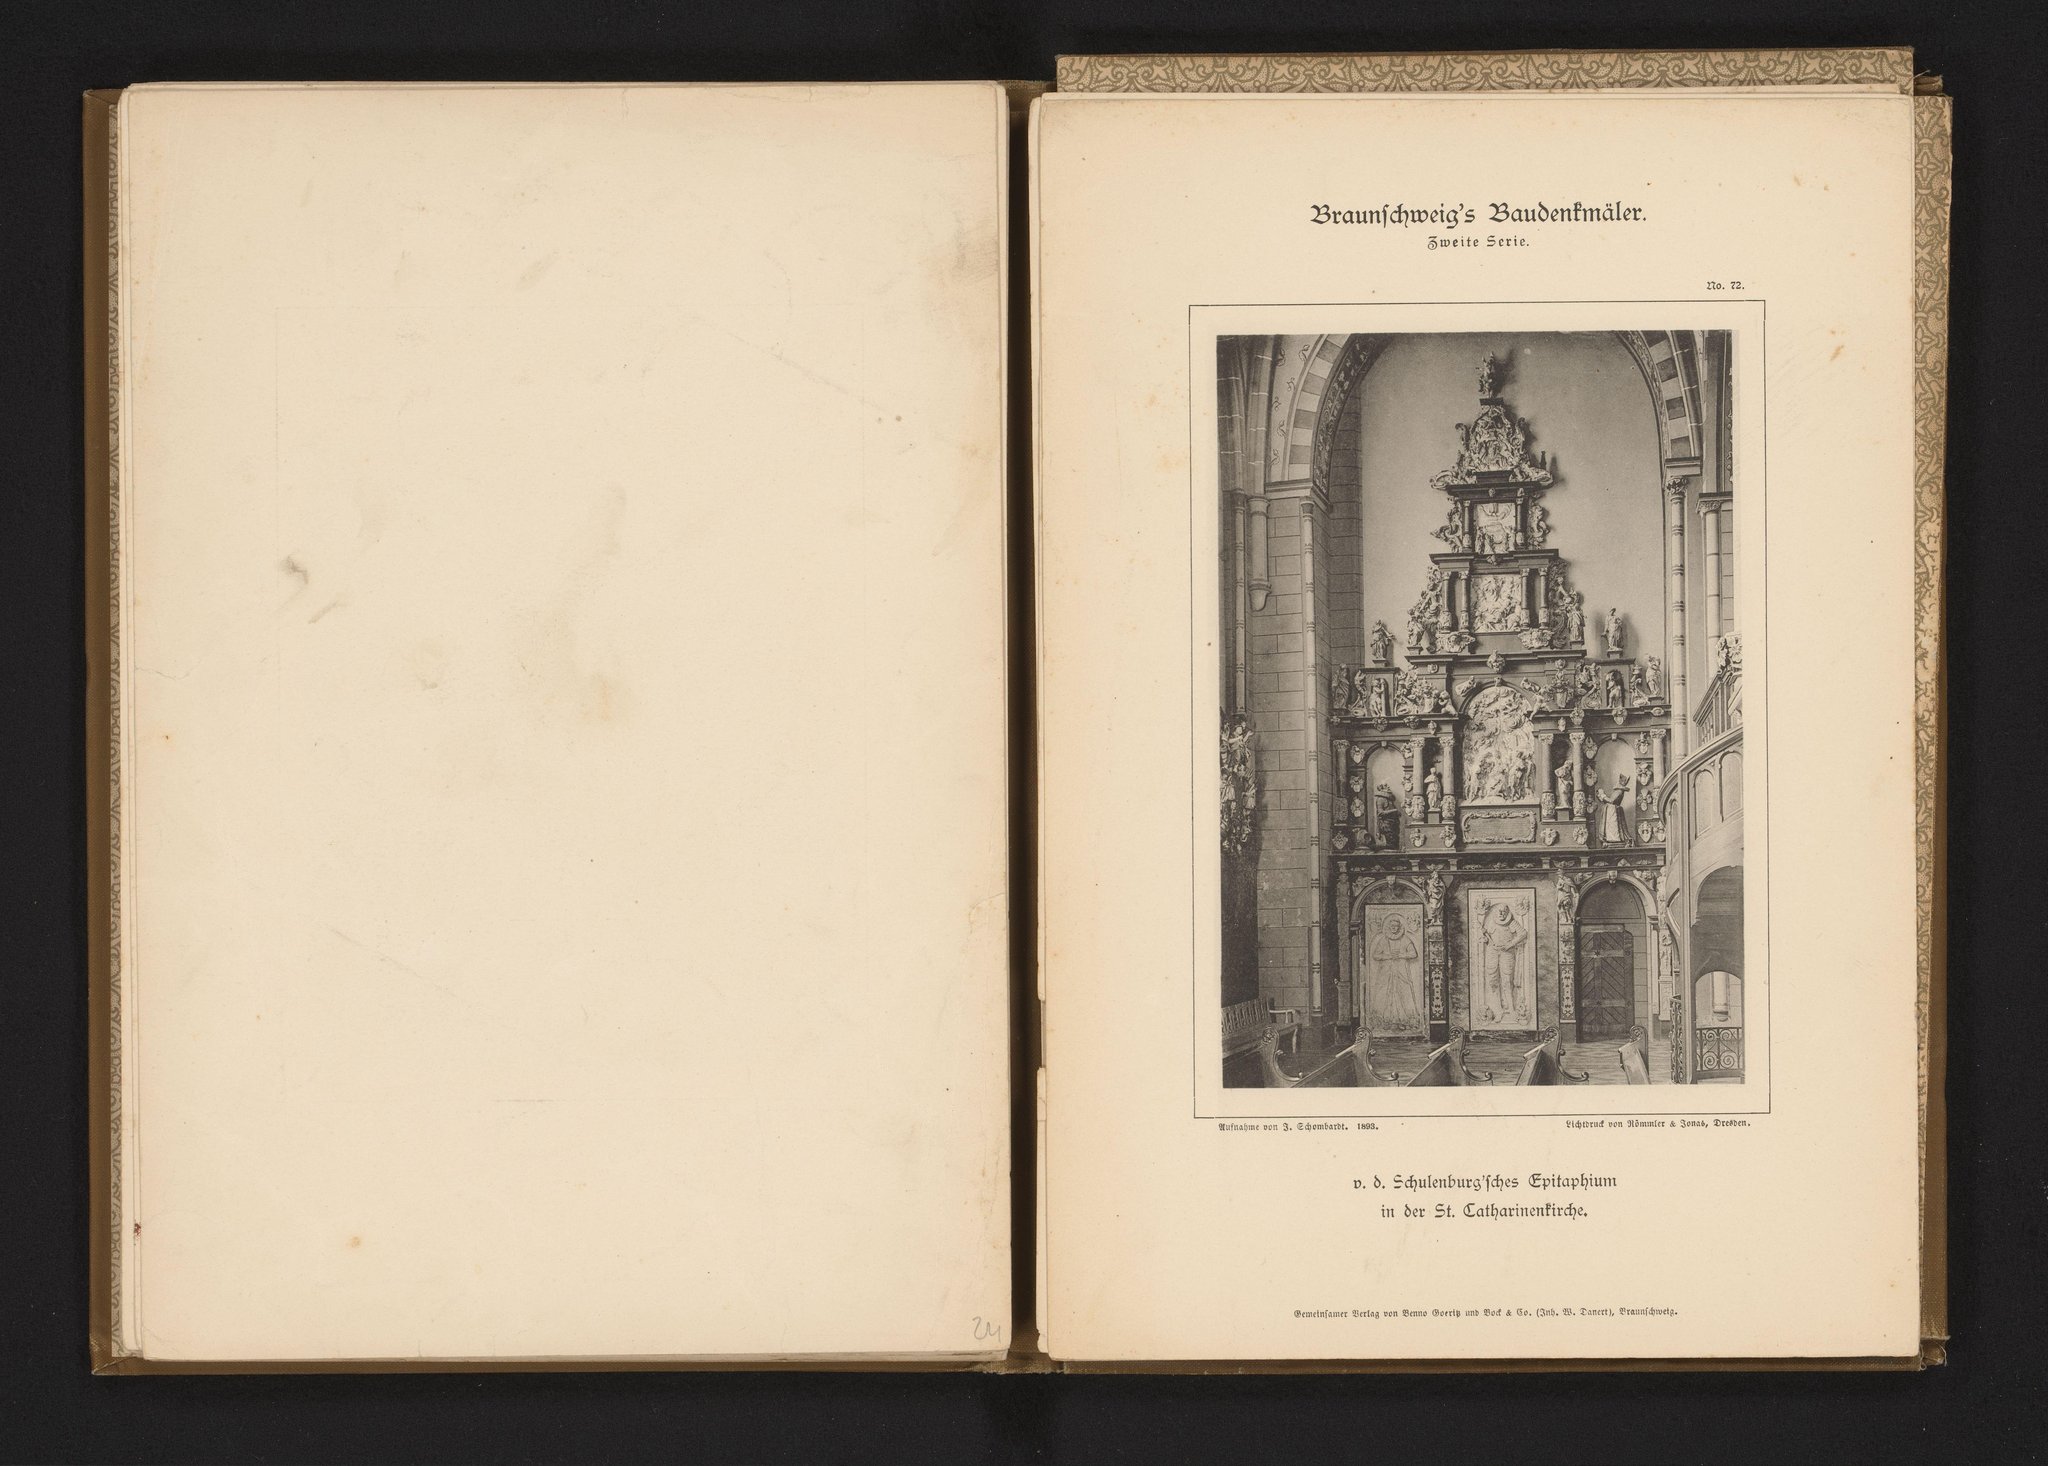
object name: page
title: v. d. Schulenburg'sches Epitaphium in der St. Catharinenkirche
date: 1893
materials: paper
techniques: photograph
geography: dresden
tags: interior of church, epitaph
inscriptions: number: ‘No. 72.’